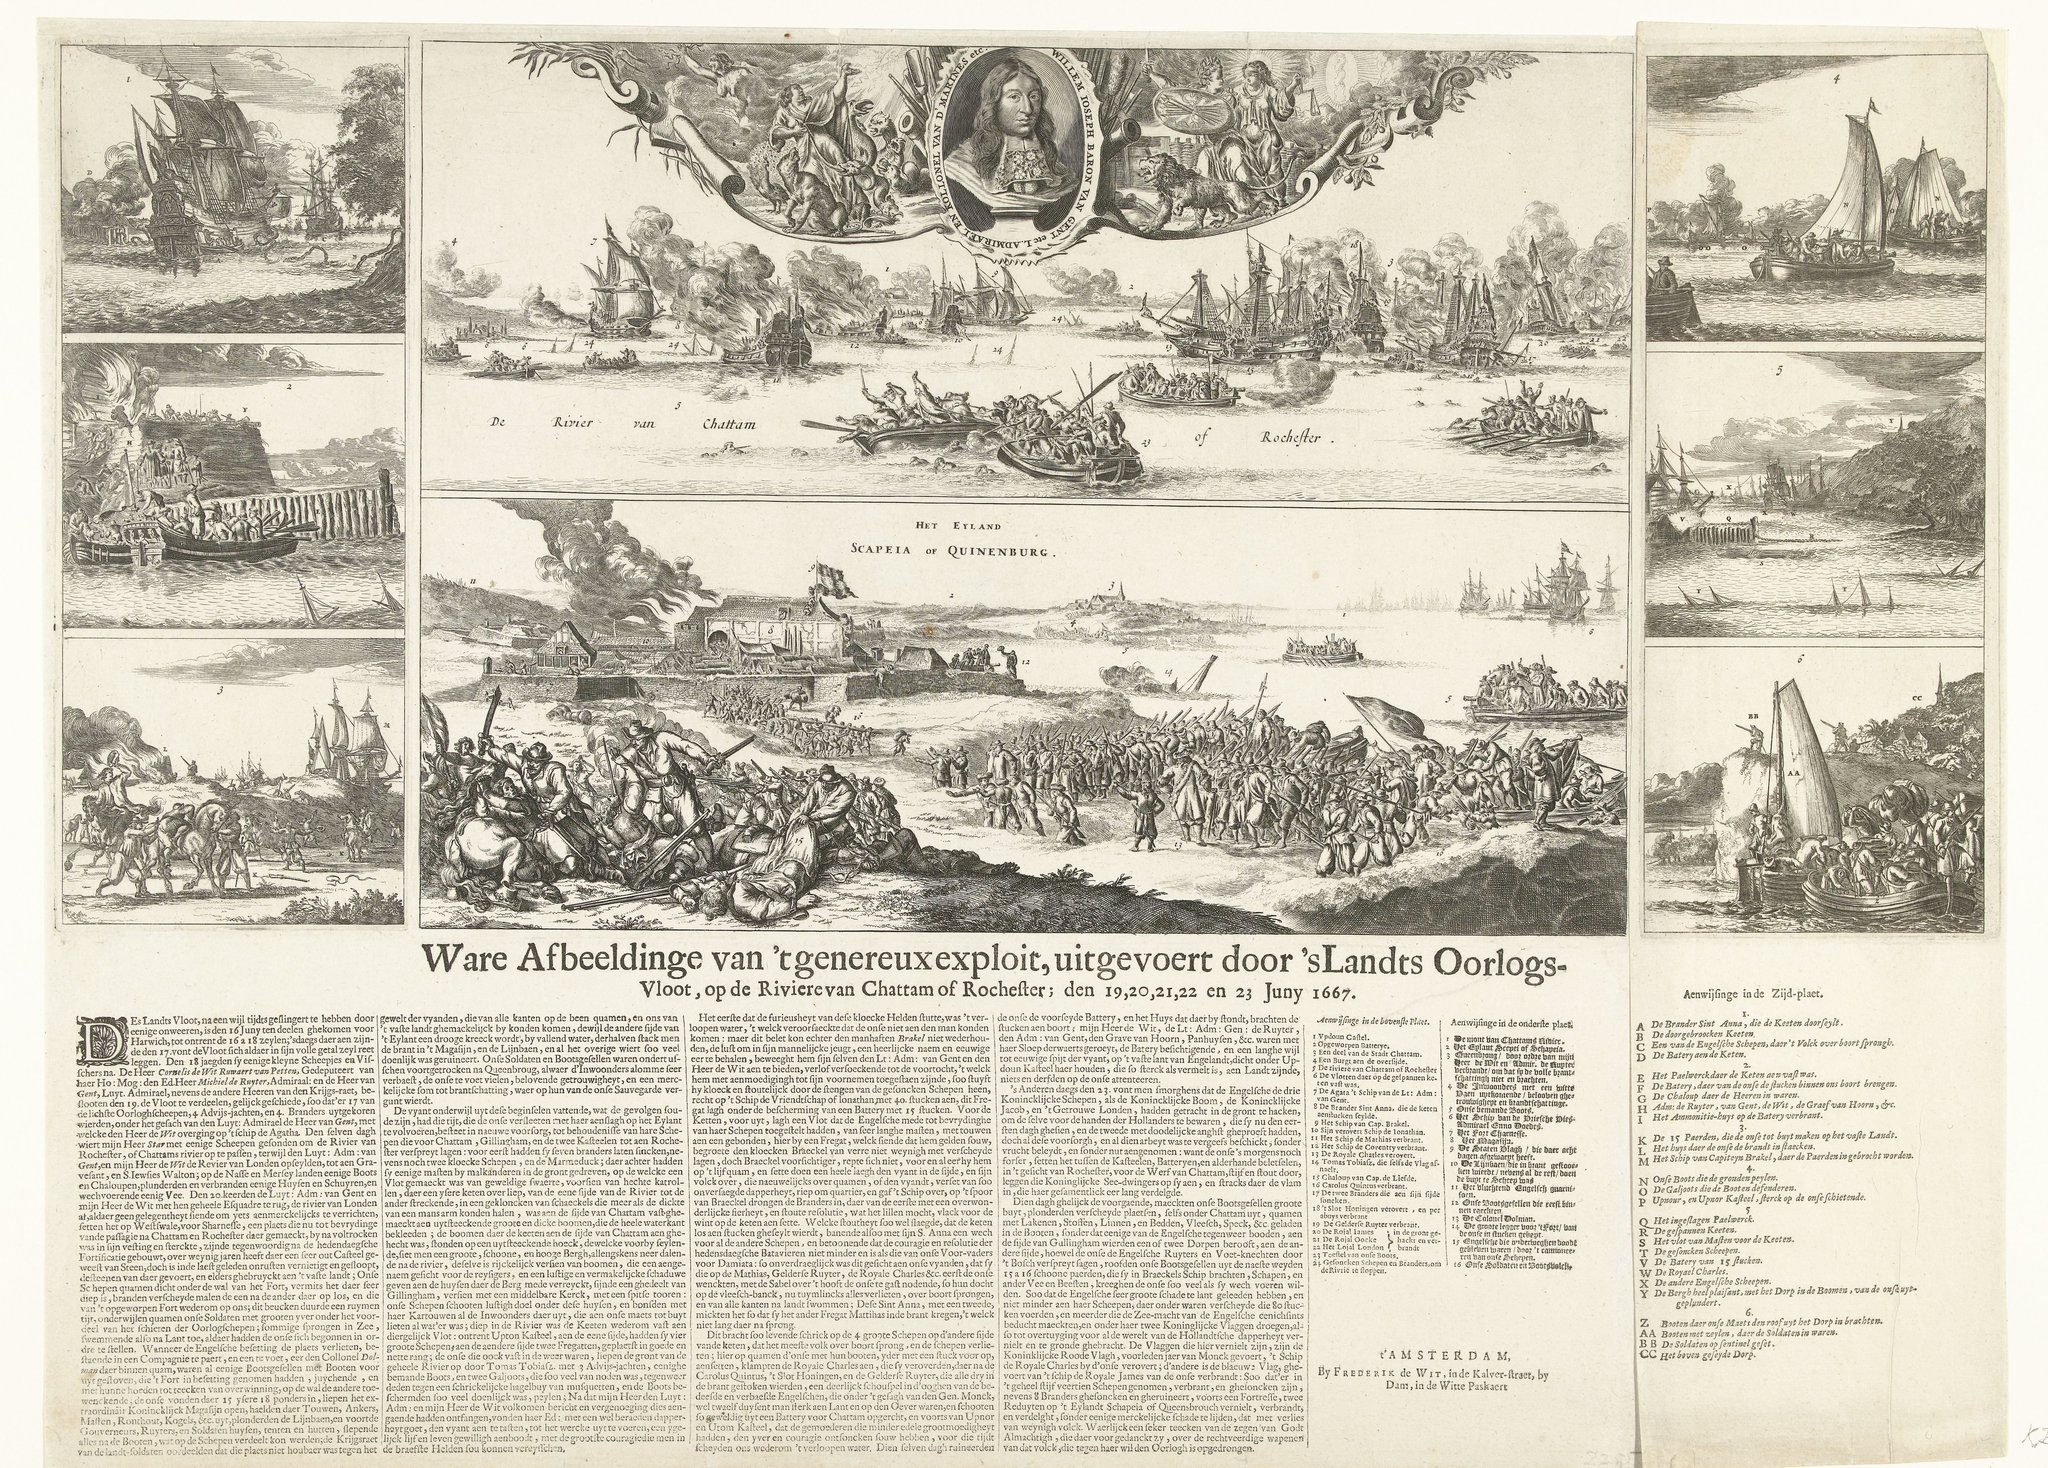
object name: print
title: Ware Af-beeldinge van 't genereux exploit, uitgevoert door 's Landts Oorlogs-Vloot, op de Riviere van Chattam of Rochester; den 19, 20, 21, 22, en 23 Juny 1667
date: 1667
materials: paper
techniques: engraving, etching, letterpress printing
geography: amsterdam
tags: flushing, michiel adriaenszoon de ruyter, willem joseph baron van gendt, battle (+ naval force), capture of city (after the siege), raid on the medway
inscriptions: collector's mark: Lugt 240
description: Blad met centraal twee voorstellingen en aan weerszijden zes kleine scènes 1-6 van de gebeurtenissen tijdens de Tocht naar Chatham. Bovenaan de vernietiging van de Engelse vloot op 20 juni 1667 door de Staatse vloot onder Michiel Adriaenszoon de Ruyter, met een portret van Willem Joseph Baron van Ghendt. Onder een voorstelling van de verovering van het eiland Sheppey met het fort en magazijn te Sheerness door de troepen van kolonel Dolman. Onderaan een beschrijving van de gebeurtenissen in 4 kolommen met hierbij de legenda's voor de centrale platen 1-24 en 1-16 en de zijplaat A-CC in het Nederlands. De drie scènes 4-6 aan de rechterzijde gedrukt op een apart los blad.